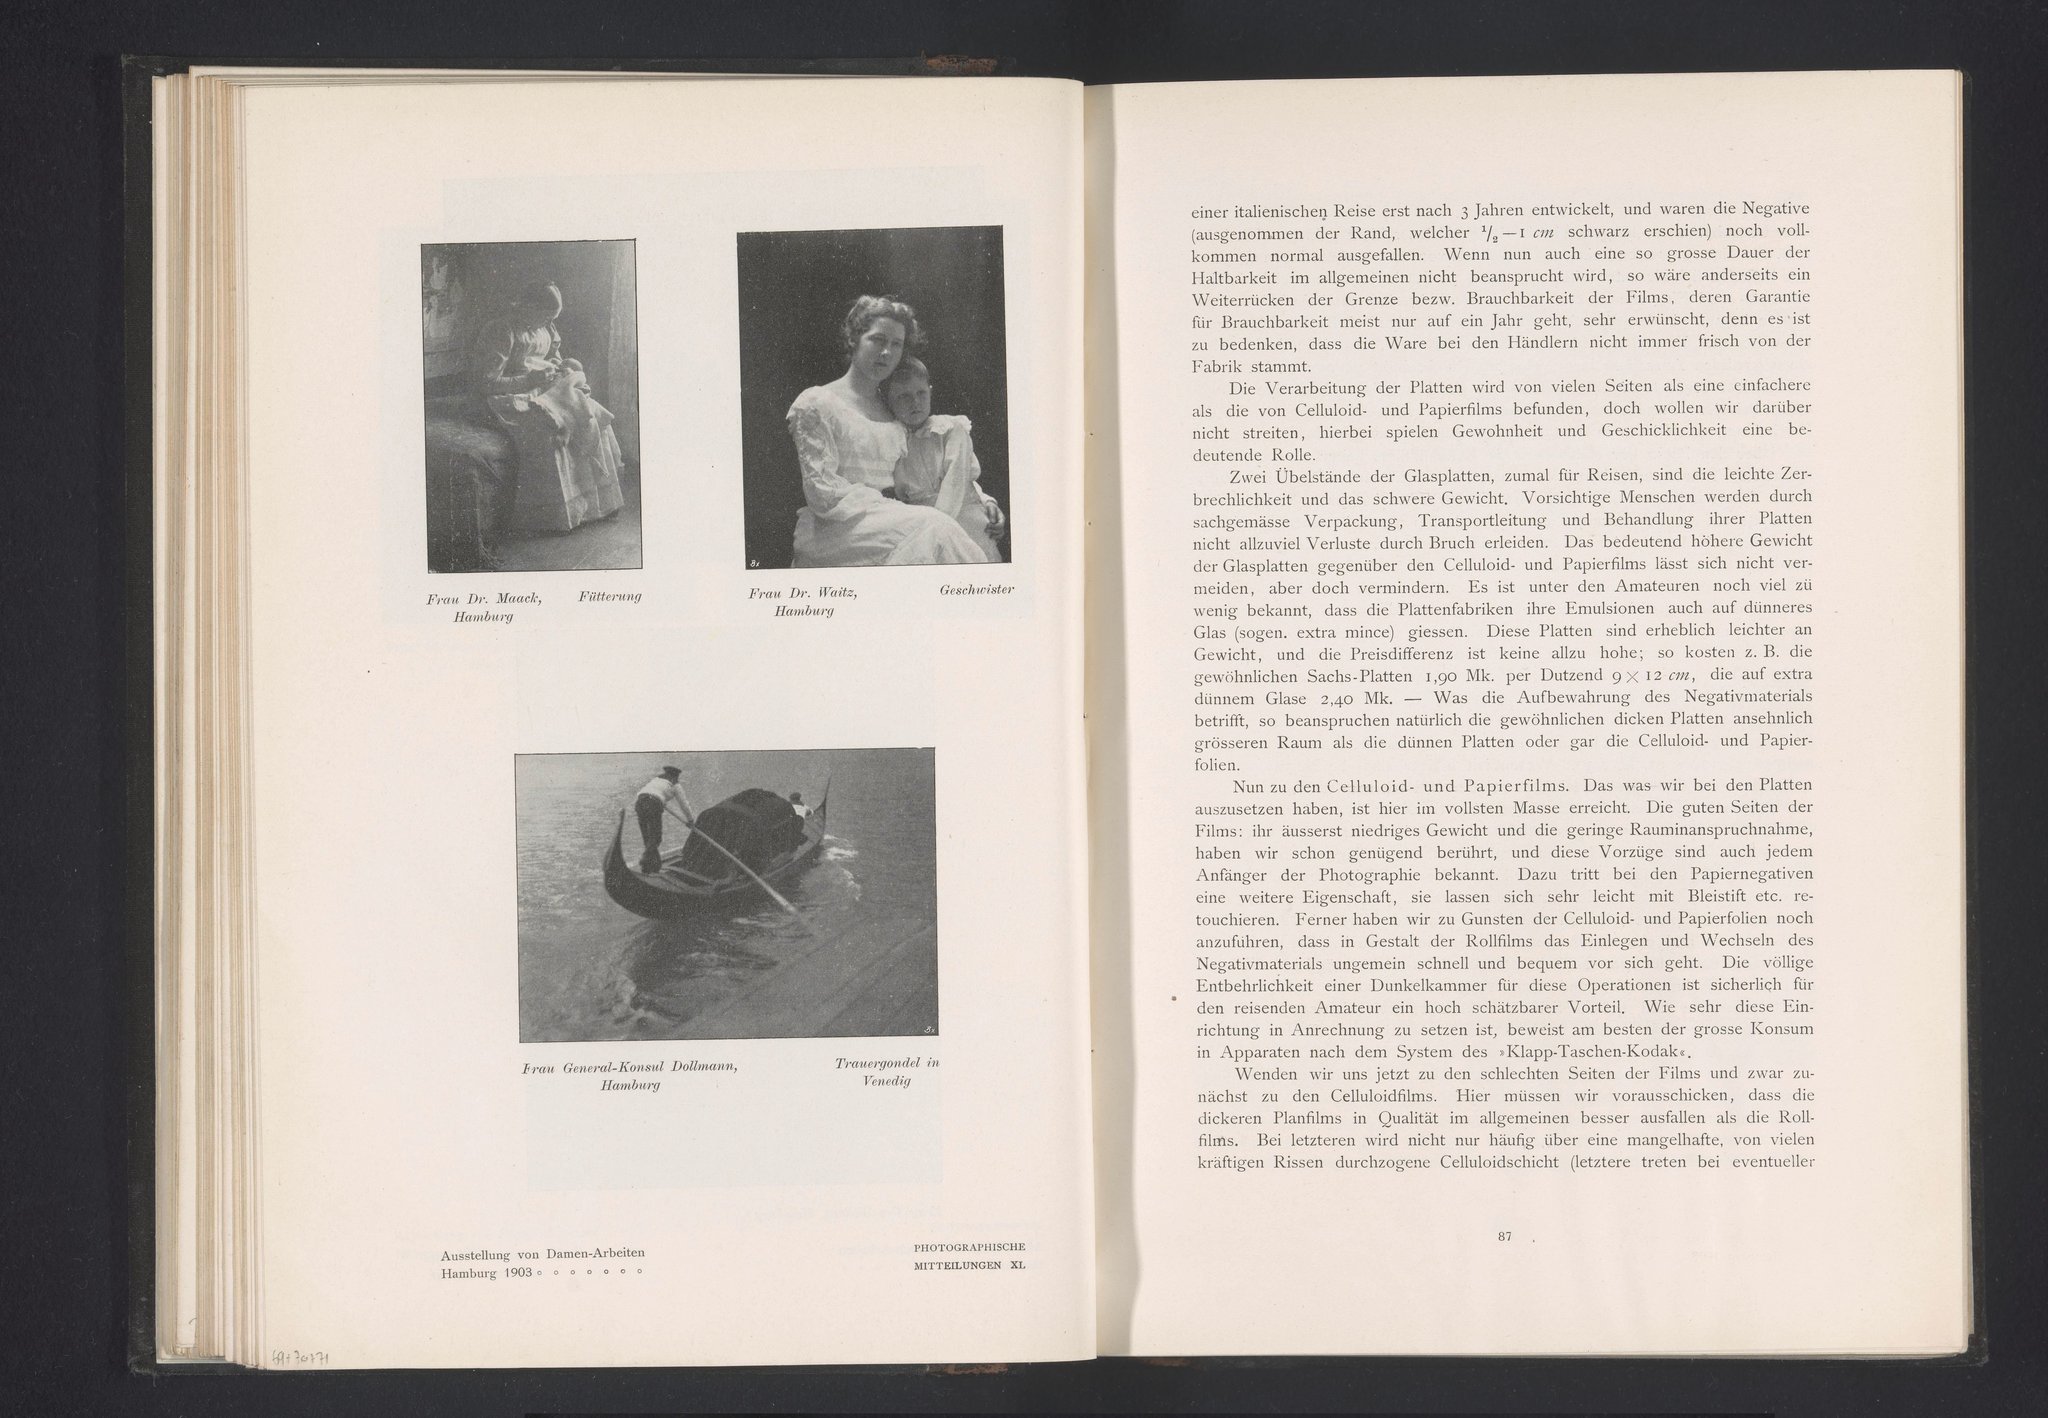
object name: photomechanical print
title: Geschwister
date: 1898-1903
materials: paper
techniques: autotype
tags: historical persons - bb - woman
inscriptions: monogram: ‘BX’, inscription: ‘Frau Dr. Waitz, Hamburg’